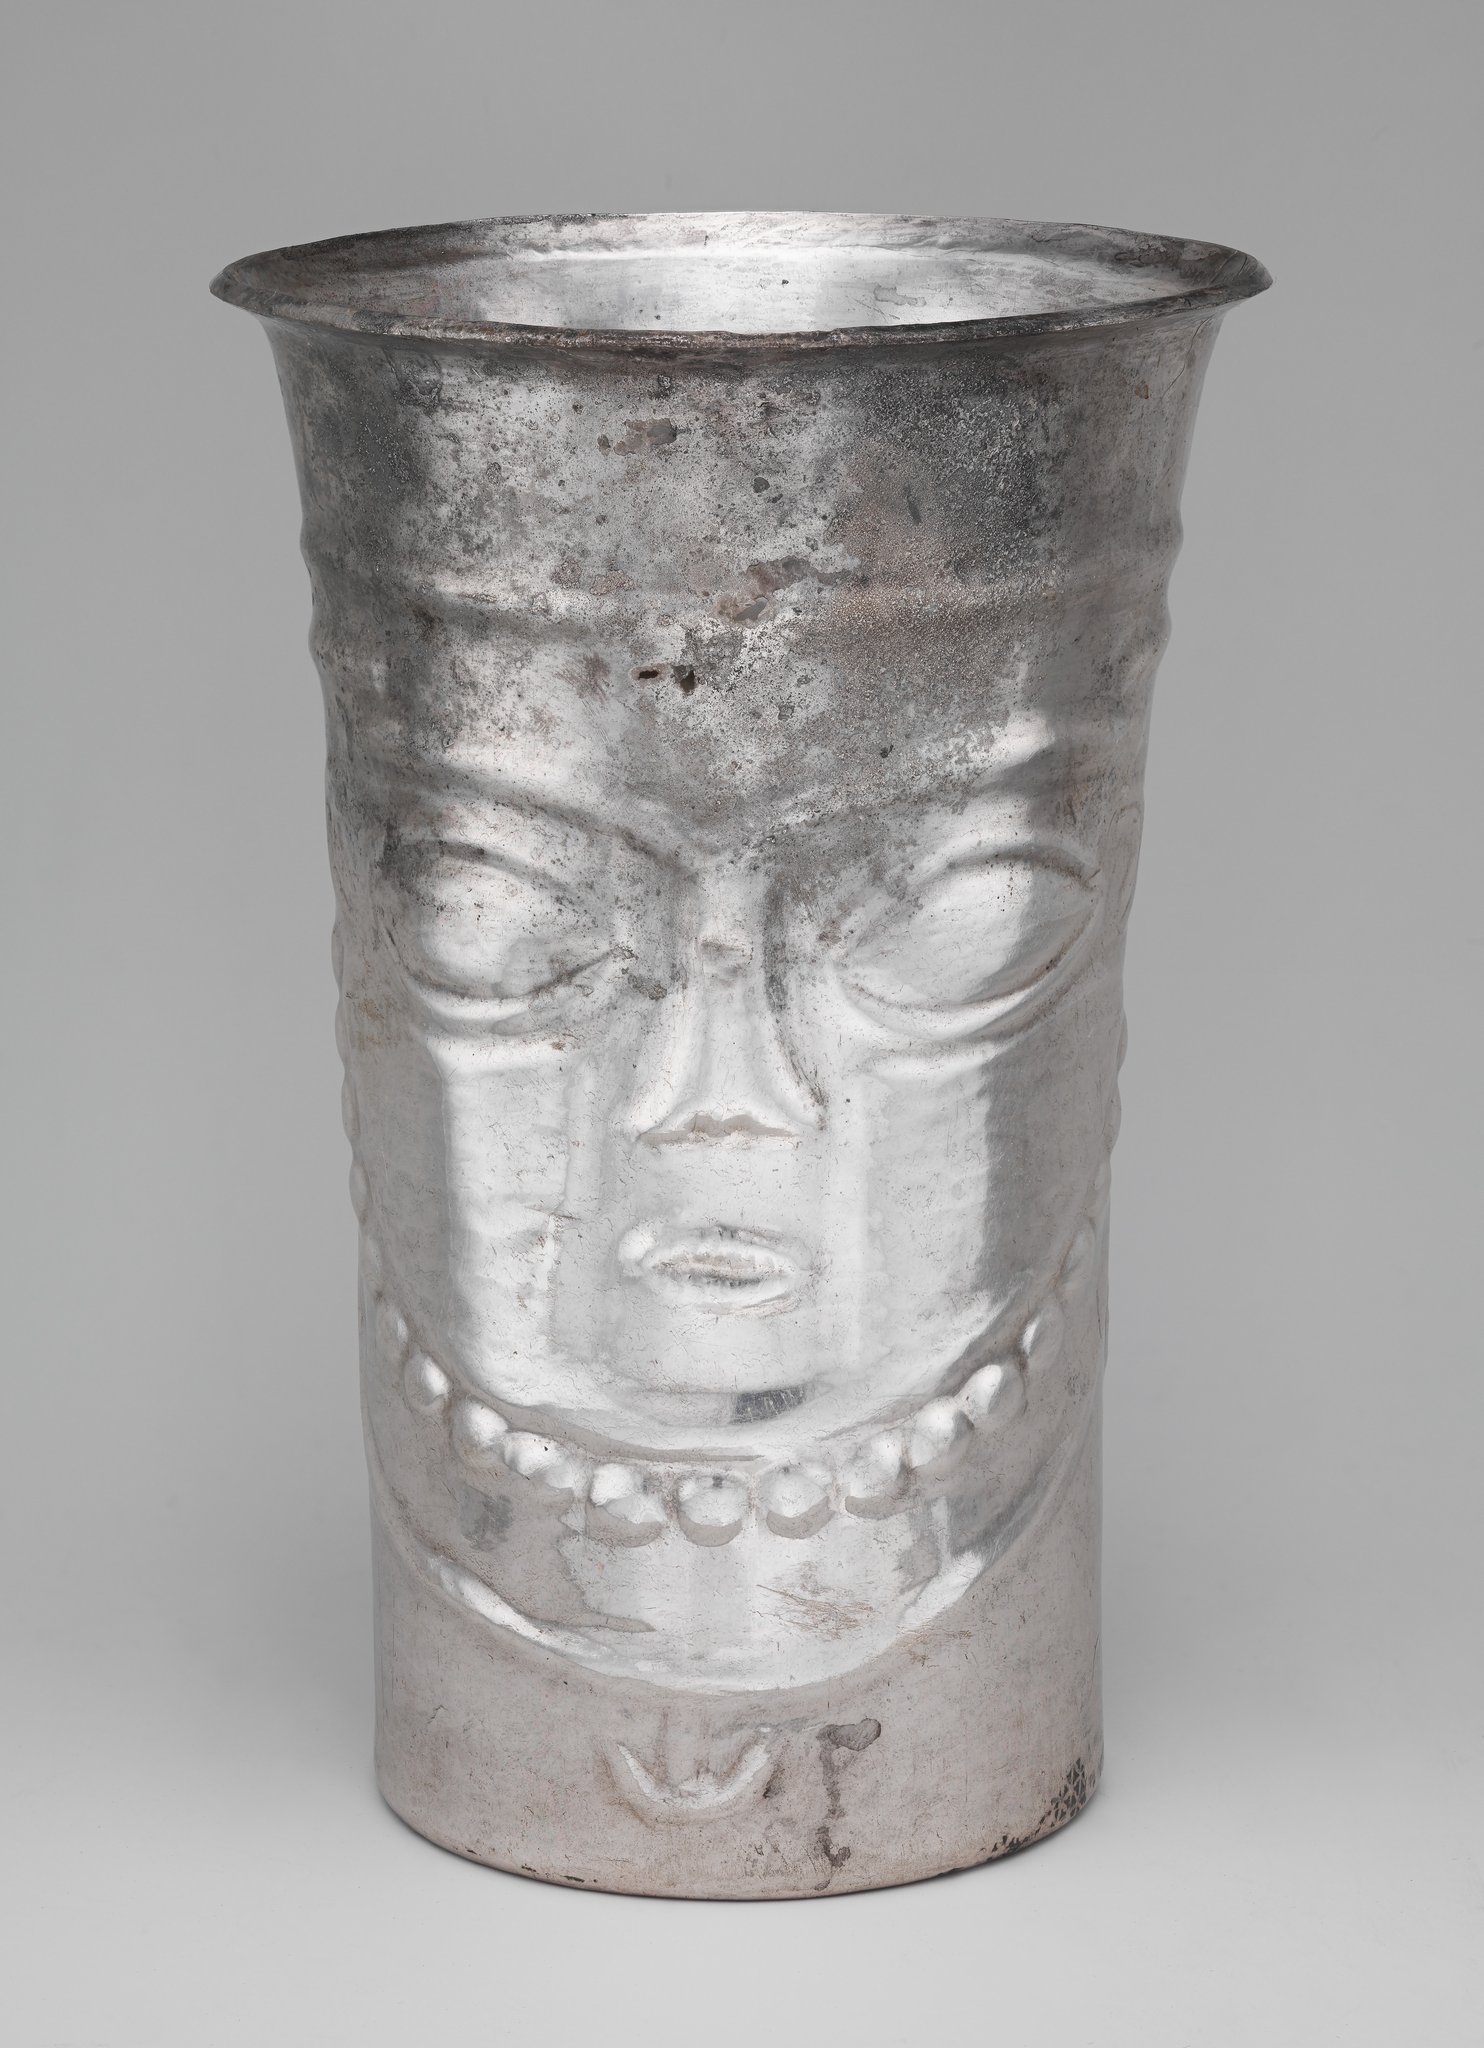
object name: beaker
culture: chimú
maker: chimú artist(s)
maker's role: artist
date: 1100-1470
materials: silver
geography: peru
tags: faces